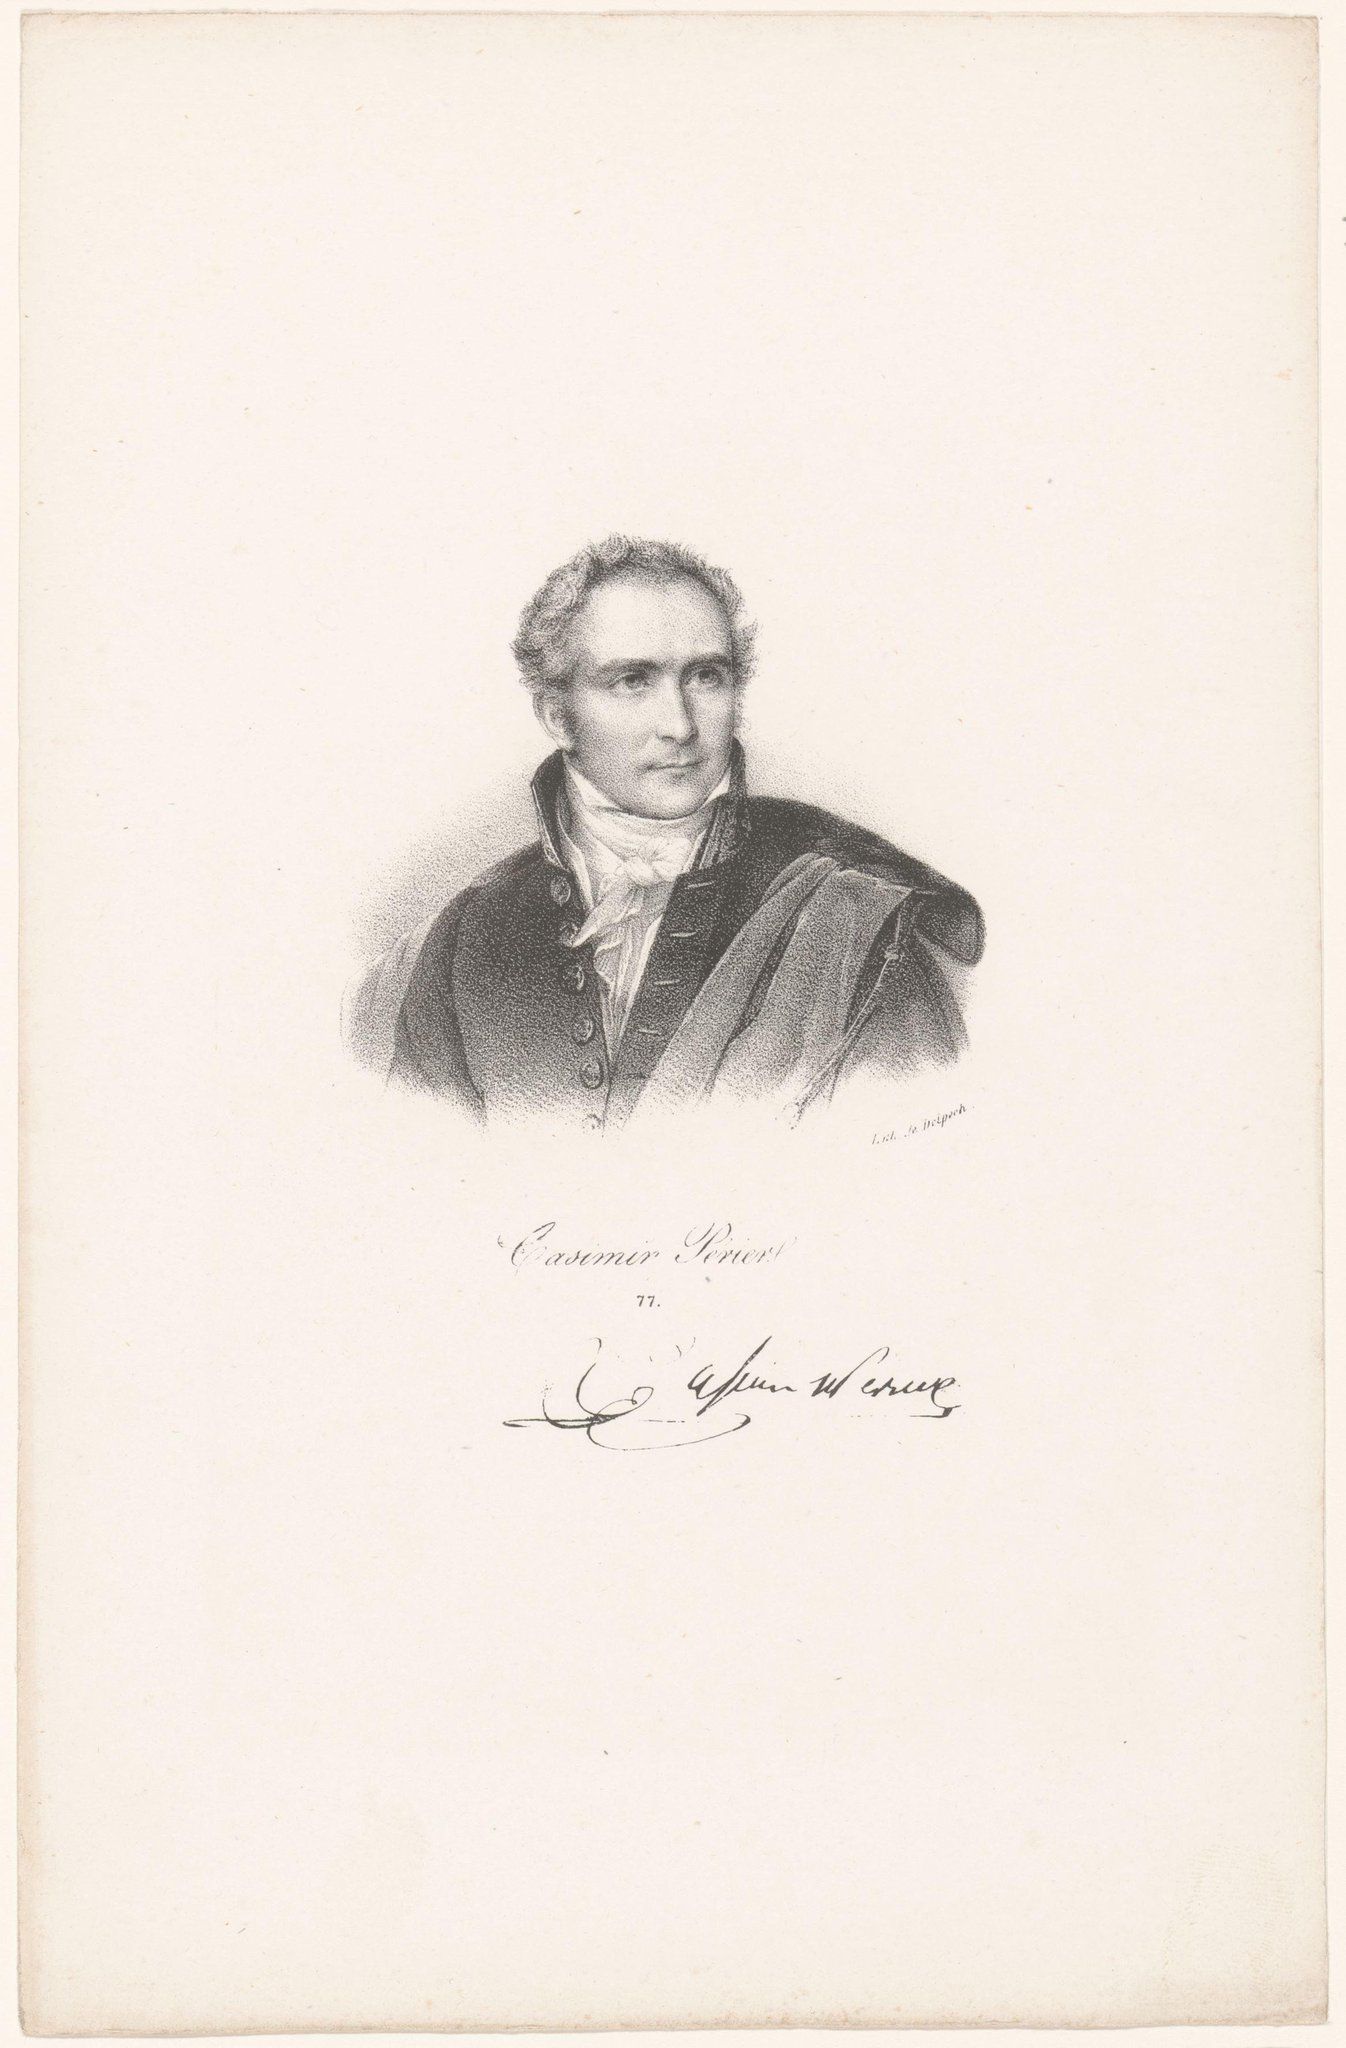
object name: print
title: Portret van Casimir-Pierre Périer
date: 1818-1842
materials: paper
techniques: lithograph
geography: paris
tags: paris, politician, historical persons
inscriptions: collector's mark: Lugt 2228a